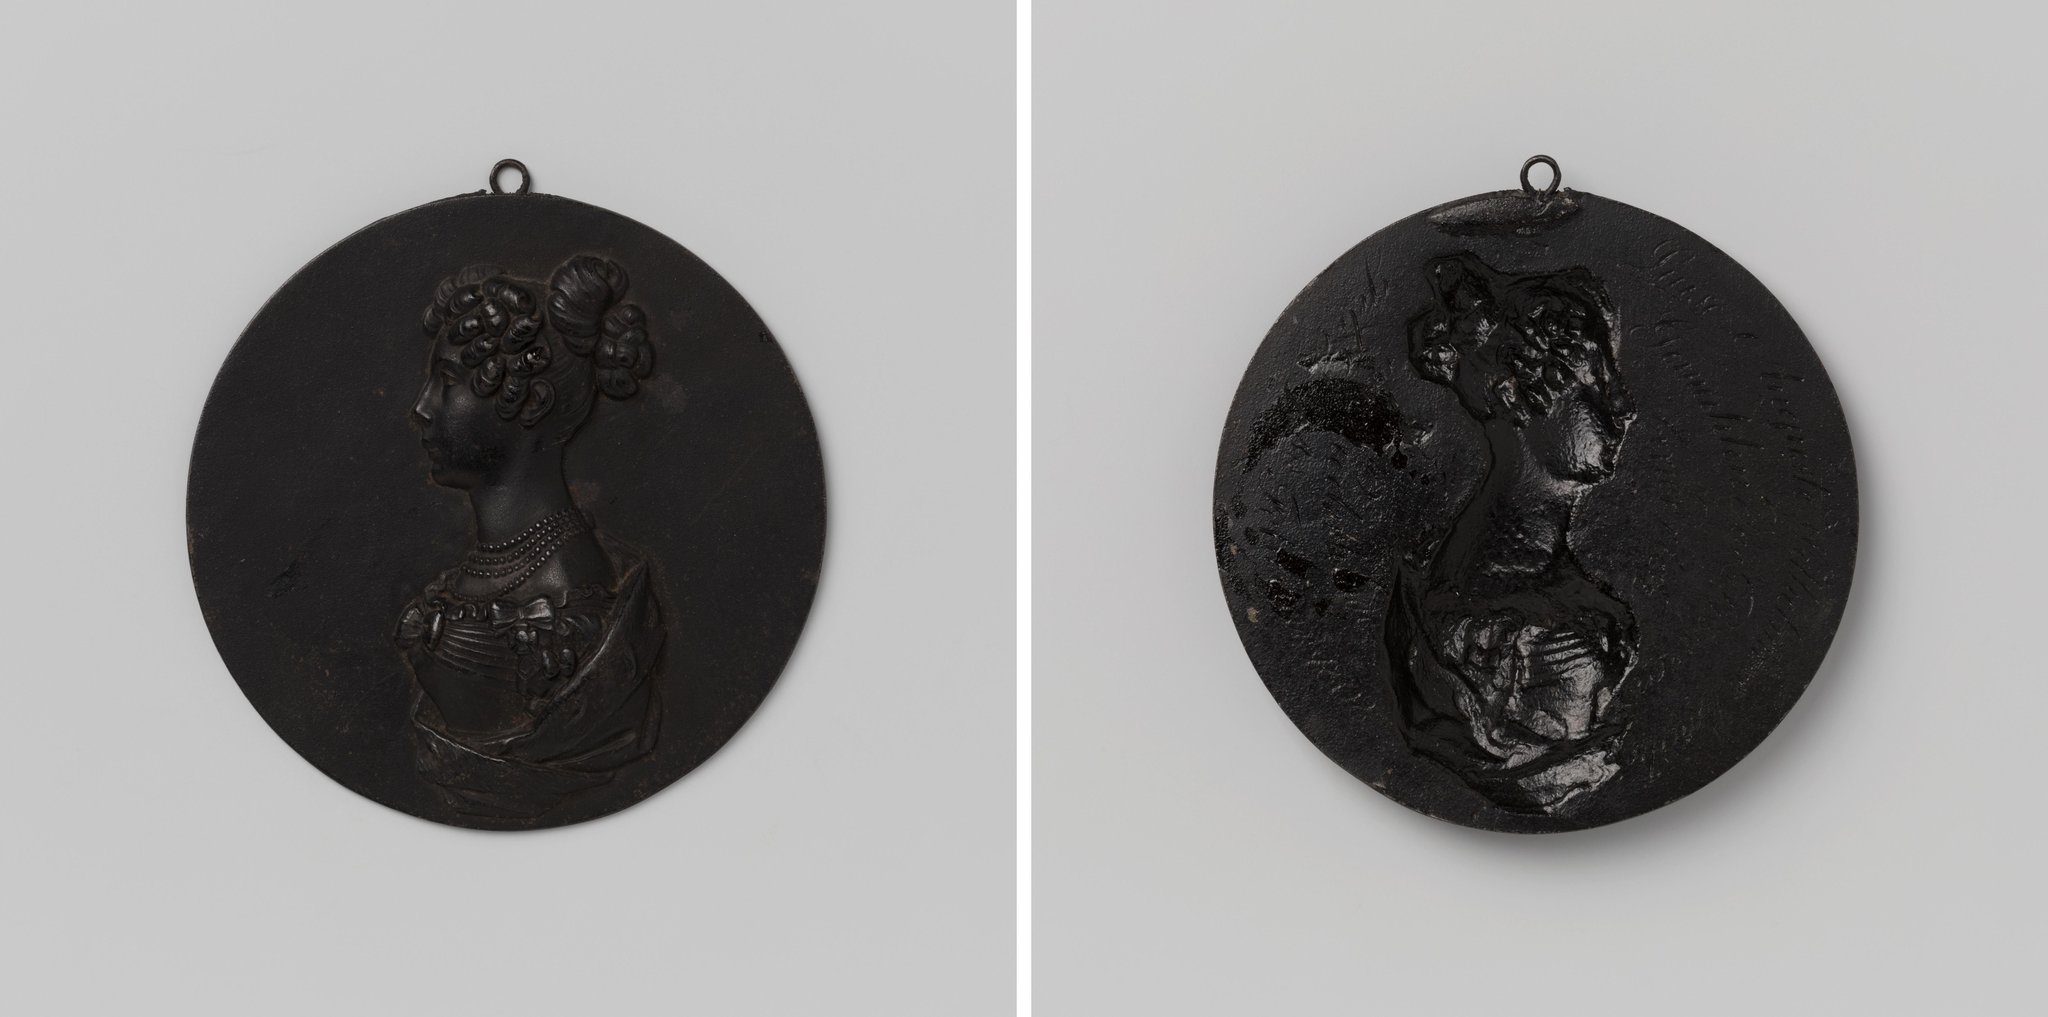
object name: plaque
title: Huwelijk van Frederik, prins der Nederlanden en Louise, prinses van Pruisen te Berlijn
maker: leonhard posch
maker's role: sculptor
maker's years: 1750-1831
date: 1825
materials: iron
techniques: casting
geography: berlin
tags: berlin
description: plaquette aan draagoog. Voorzijde: borststuk vrouw naar links. Keerzijde: opschrift: "Luise Auguste Wilhelmine Amalie / Gemahlin des Prinzen / Friedrich / der Niederlande / geb d 1tn Februar 1808"